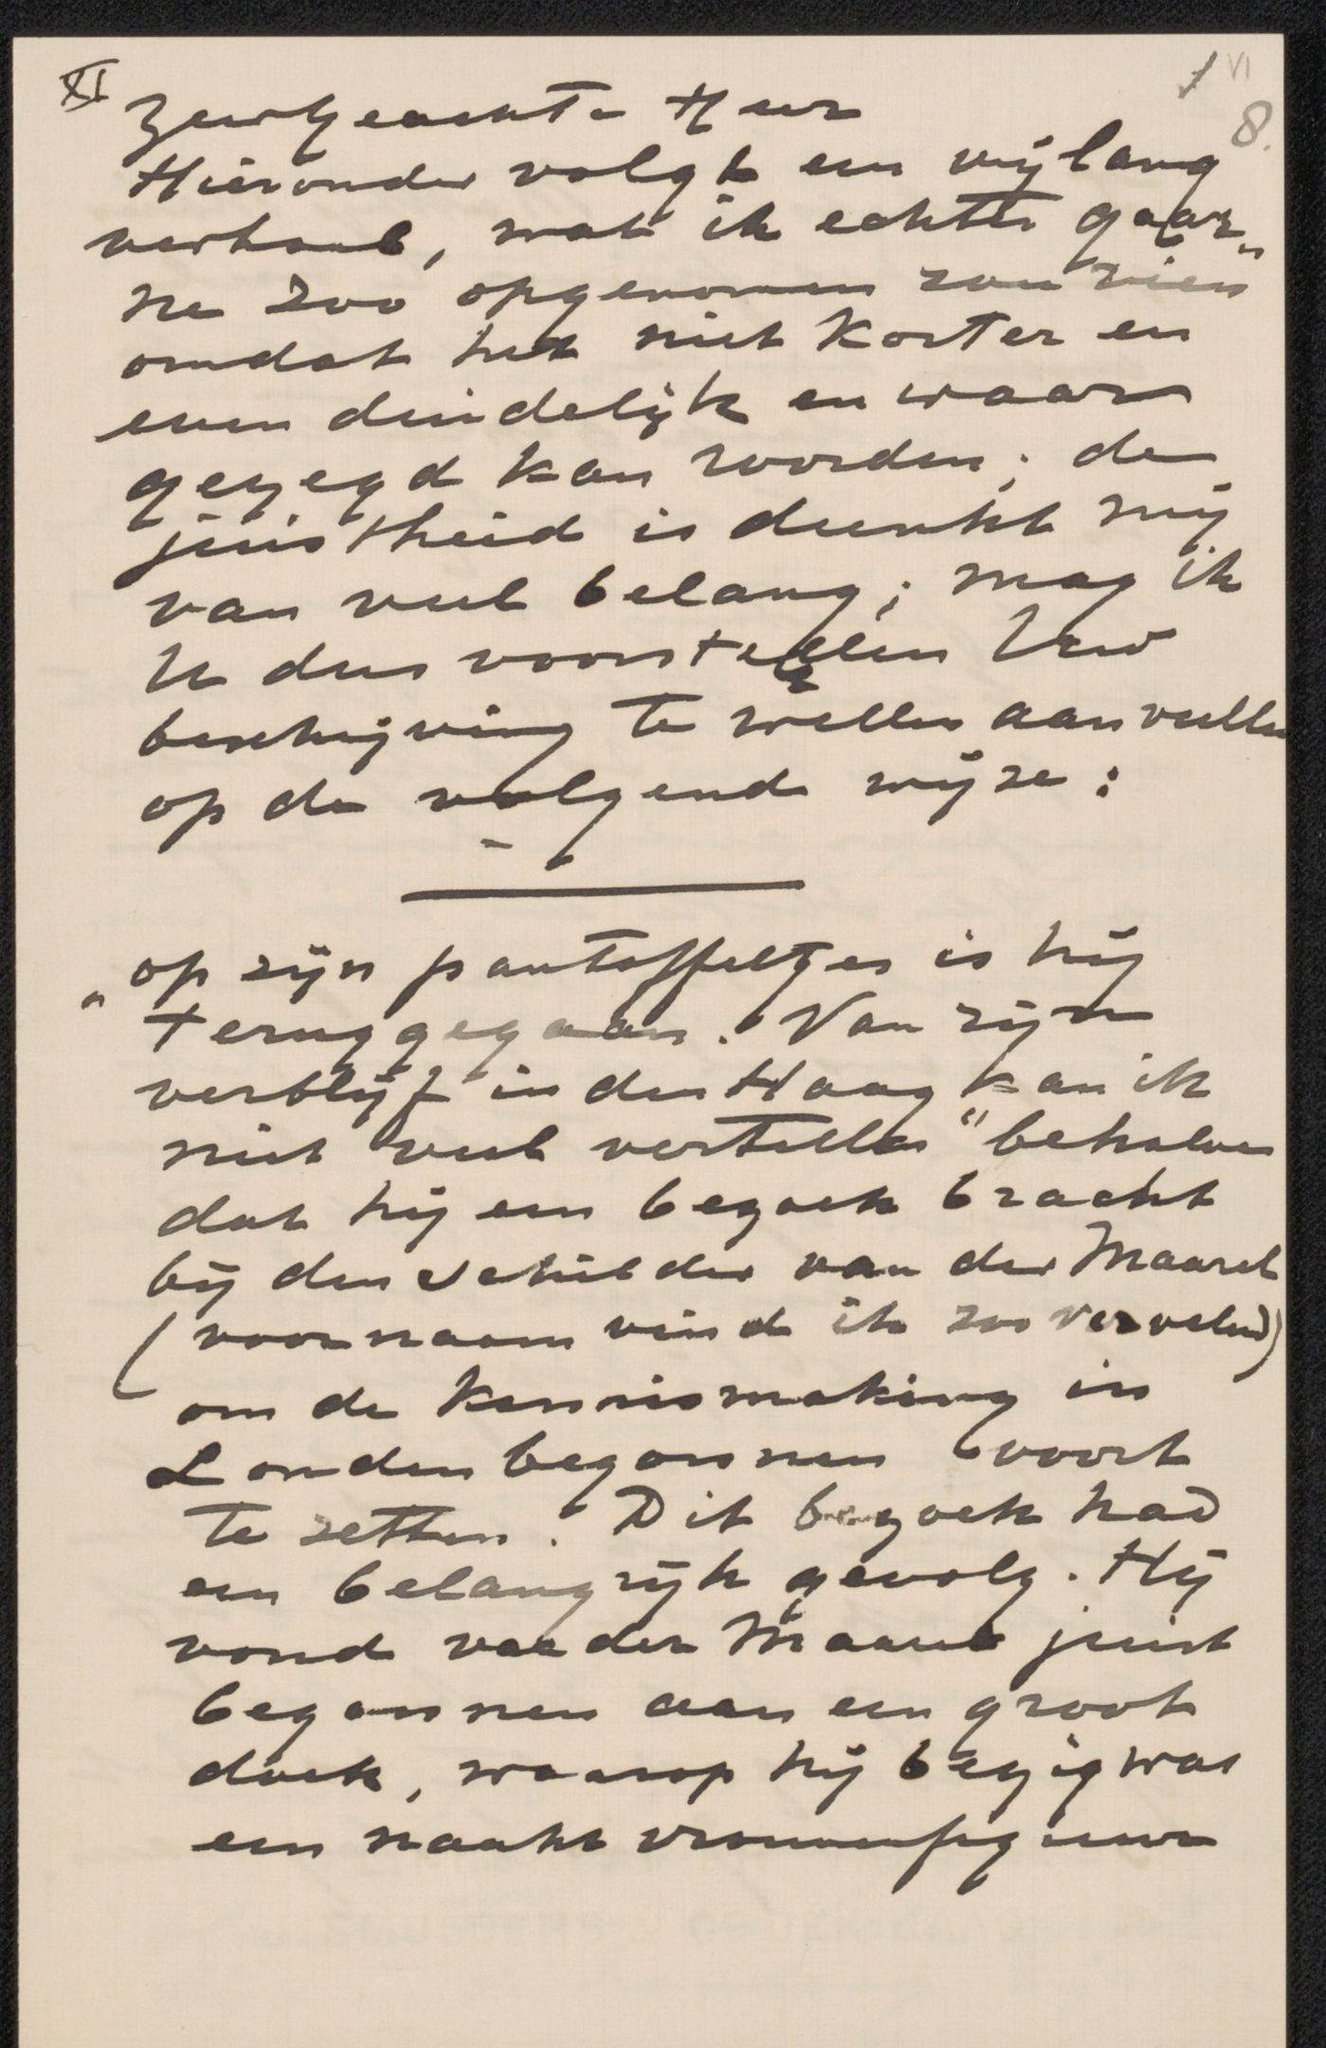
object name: letter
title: Brief aan Pieter Haverkorn van Rijsewijk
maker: Anonymous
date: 1911-1912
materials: ink, paper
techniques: pen, writing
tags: print maker, matthijs maris, the hague, painter, draughtsman, marinus van der maarel, pieter haverkorn van rijsewijk, elbert jan van wisselingh, painting (including book-illumination, miniature-painting), workshop, studio of the artist (in general), london